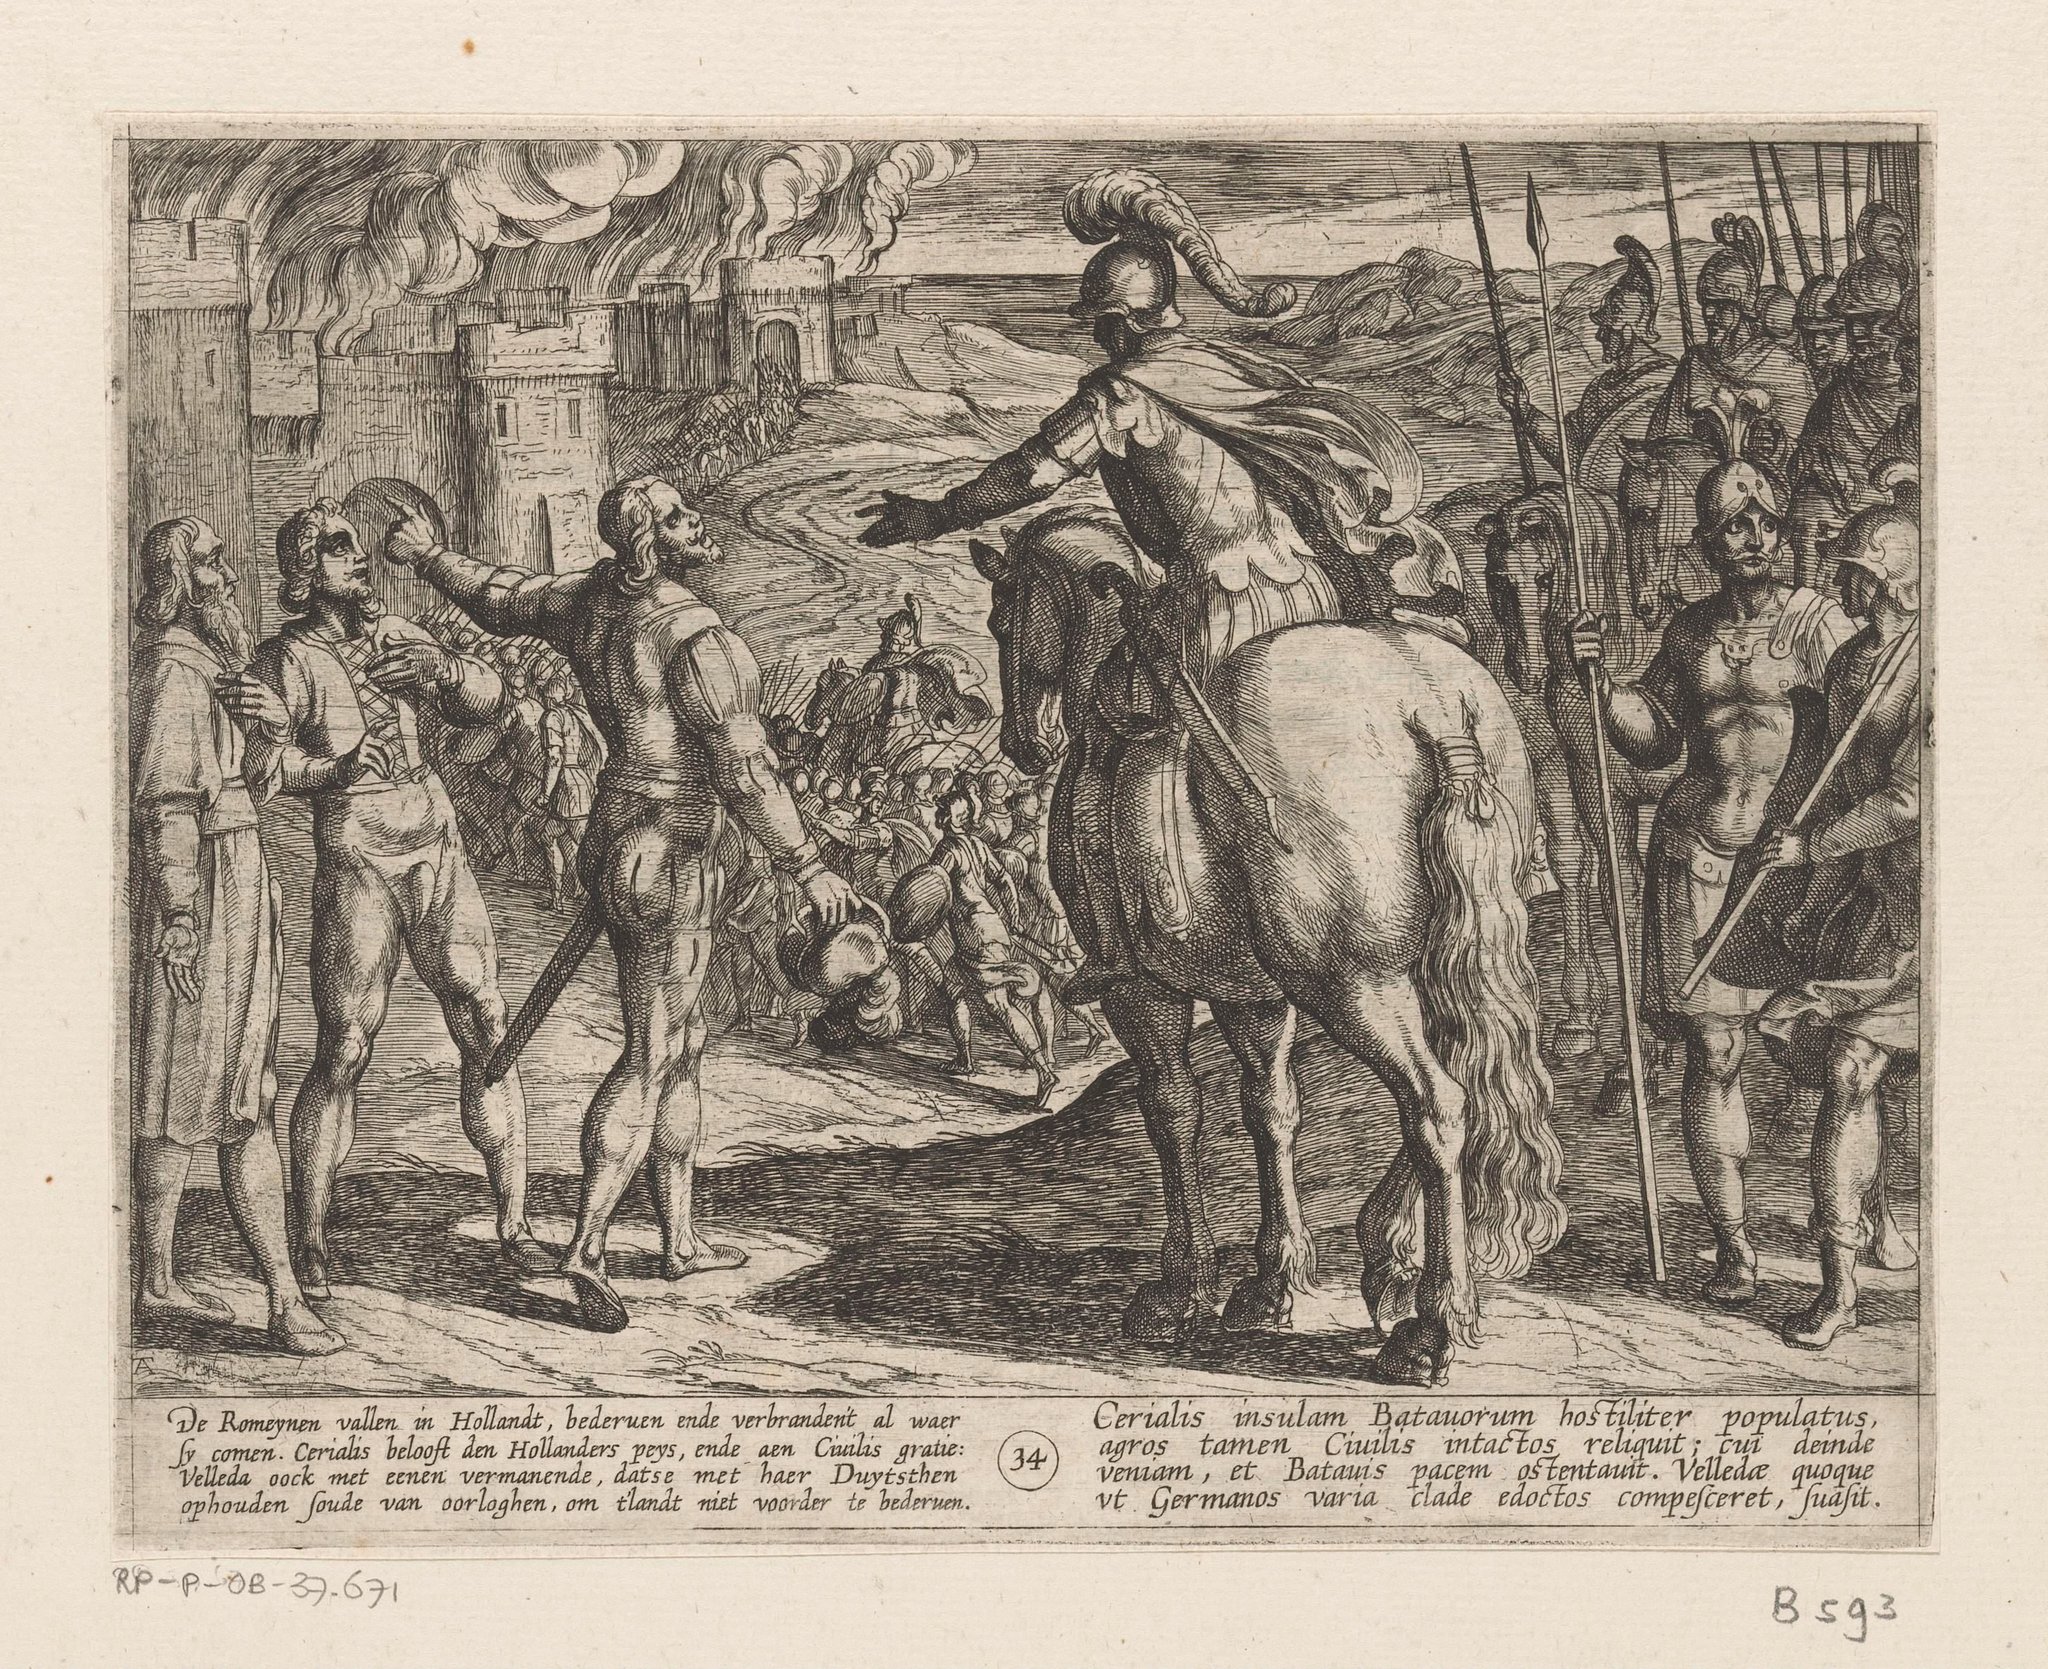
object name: print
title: De Bataafse oorlogen tegen de Romeinen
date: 1611-1612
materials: paper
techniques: etching, letterpress printing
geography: southern netherlands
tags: battle, the soldier; the soldier's life, burning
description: De Romeinse troepen verbranden Nederlandse nederzettingen op het platteland. Onderschrift in het Nederlands en in het Latijn.